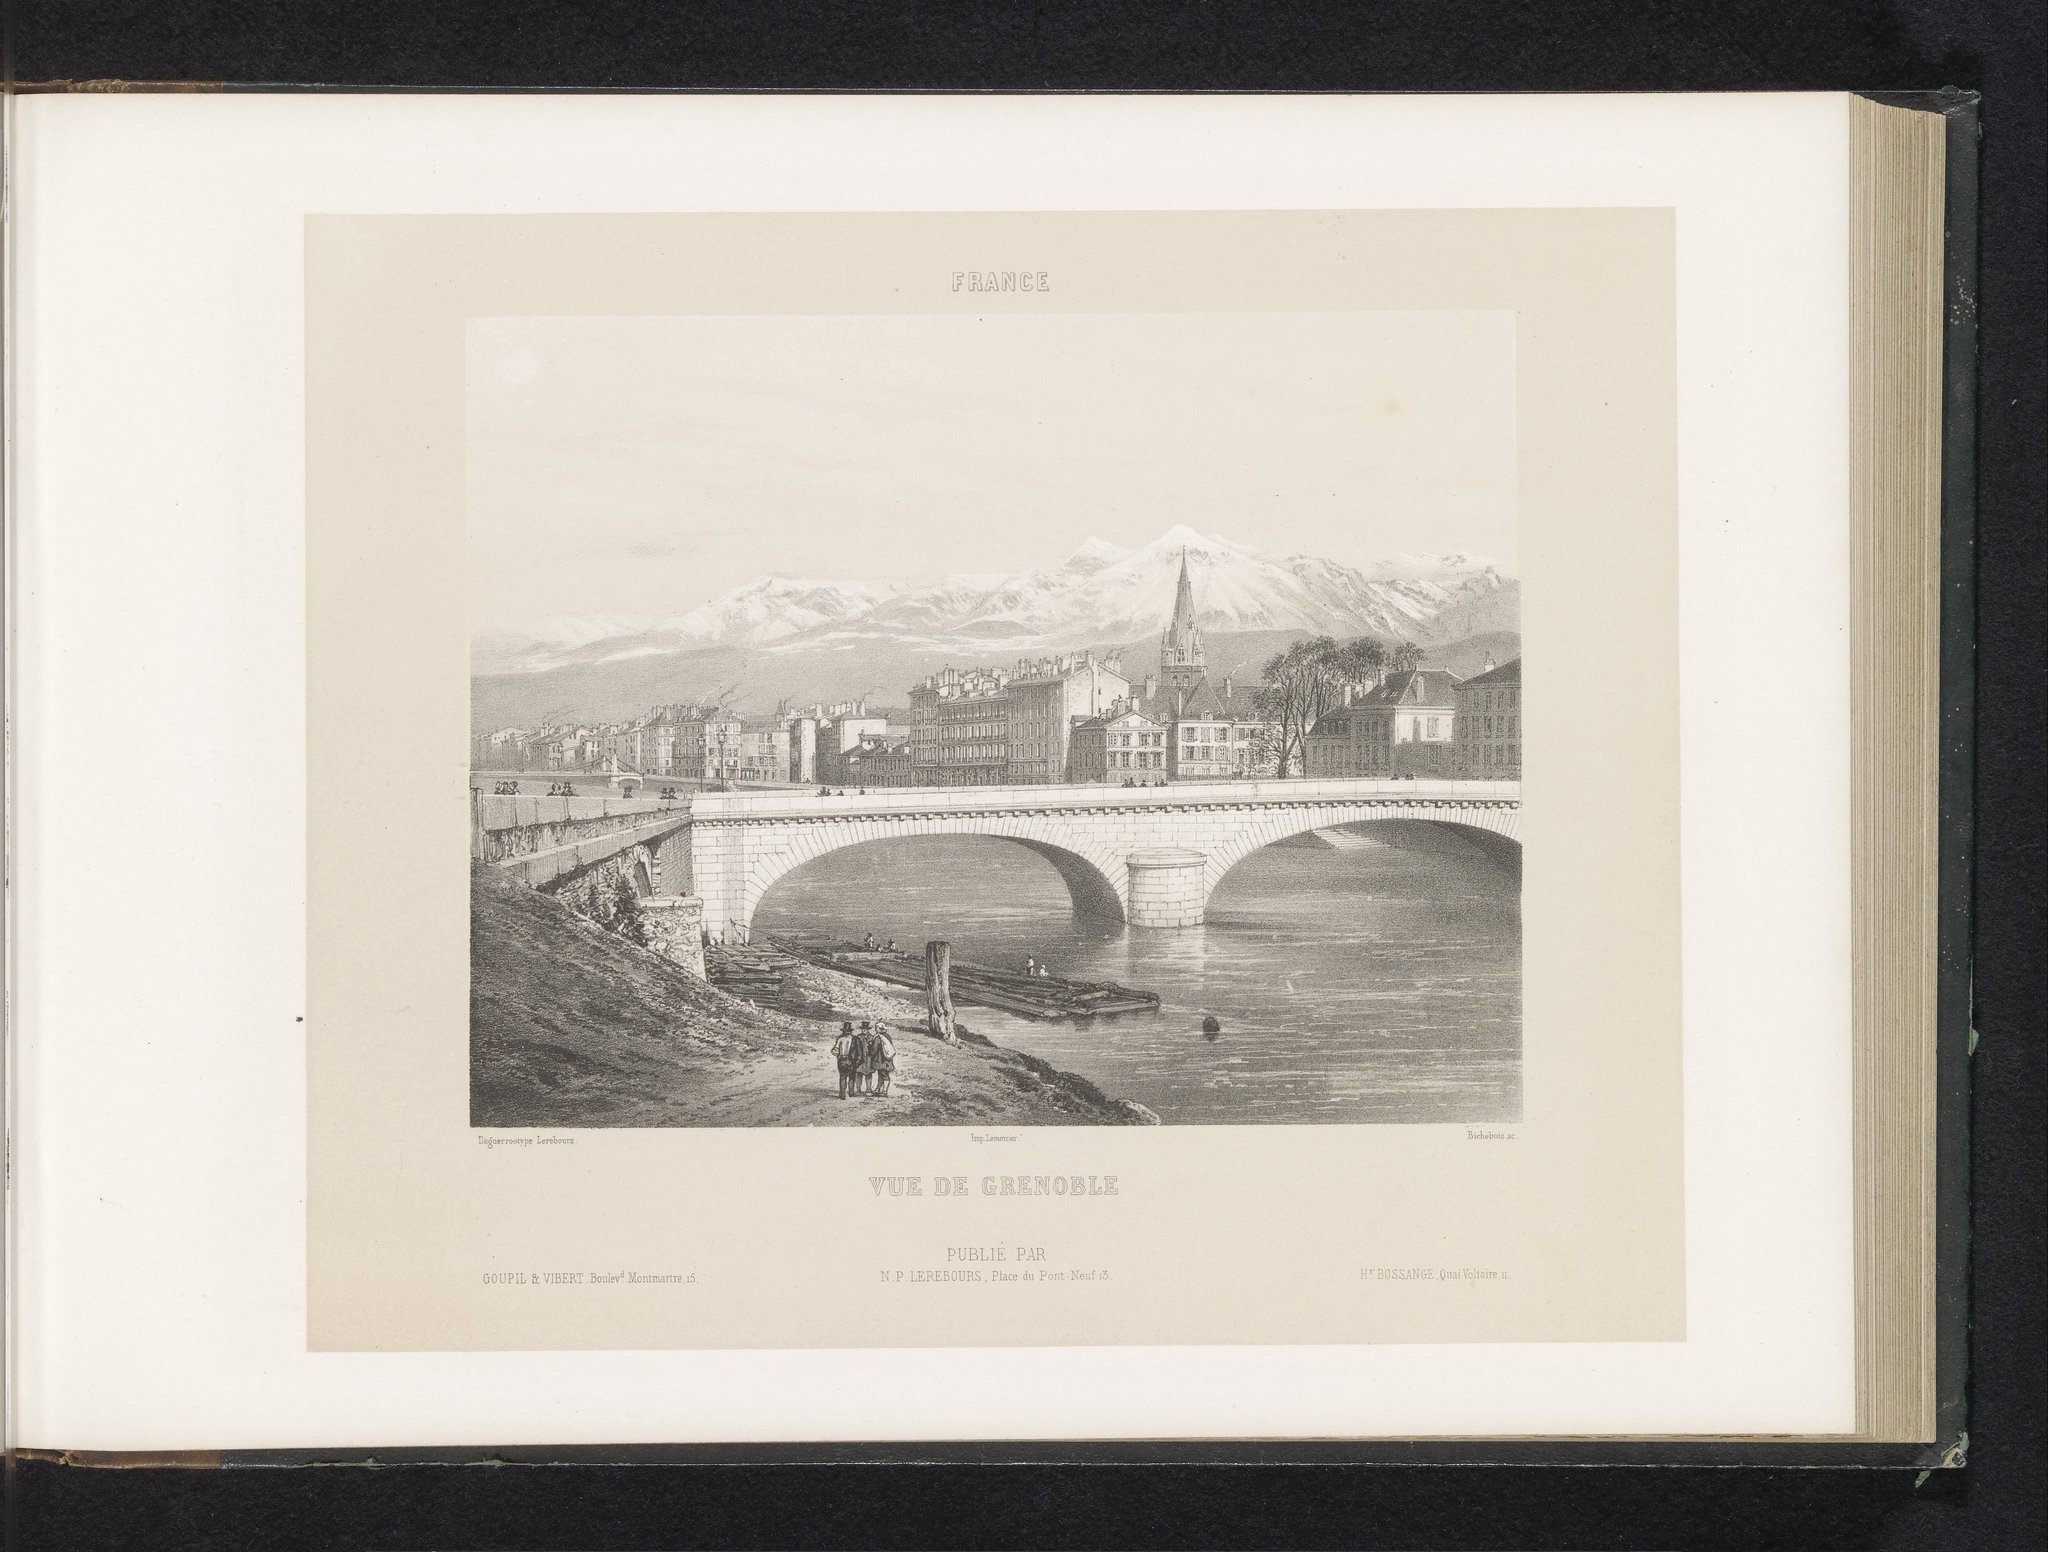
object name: print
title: France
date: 1839-1841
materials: paper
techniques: aquatint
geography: paris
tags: city-view in general; 'veduta', landscape with bridge, viaduct or aqueduct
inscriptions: inscription: ‘Hr. Bossance Quai Voltaire 11’, inscription: ‘N.P. Lerebours Place du Pont Neuf 15’, inscription: ‘Rittner & Goupil Boulevd Montmartre 15’